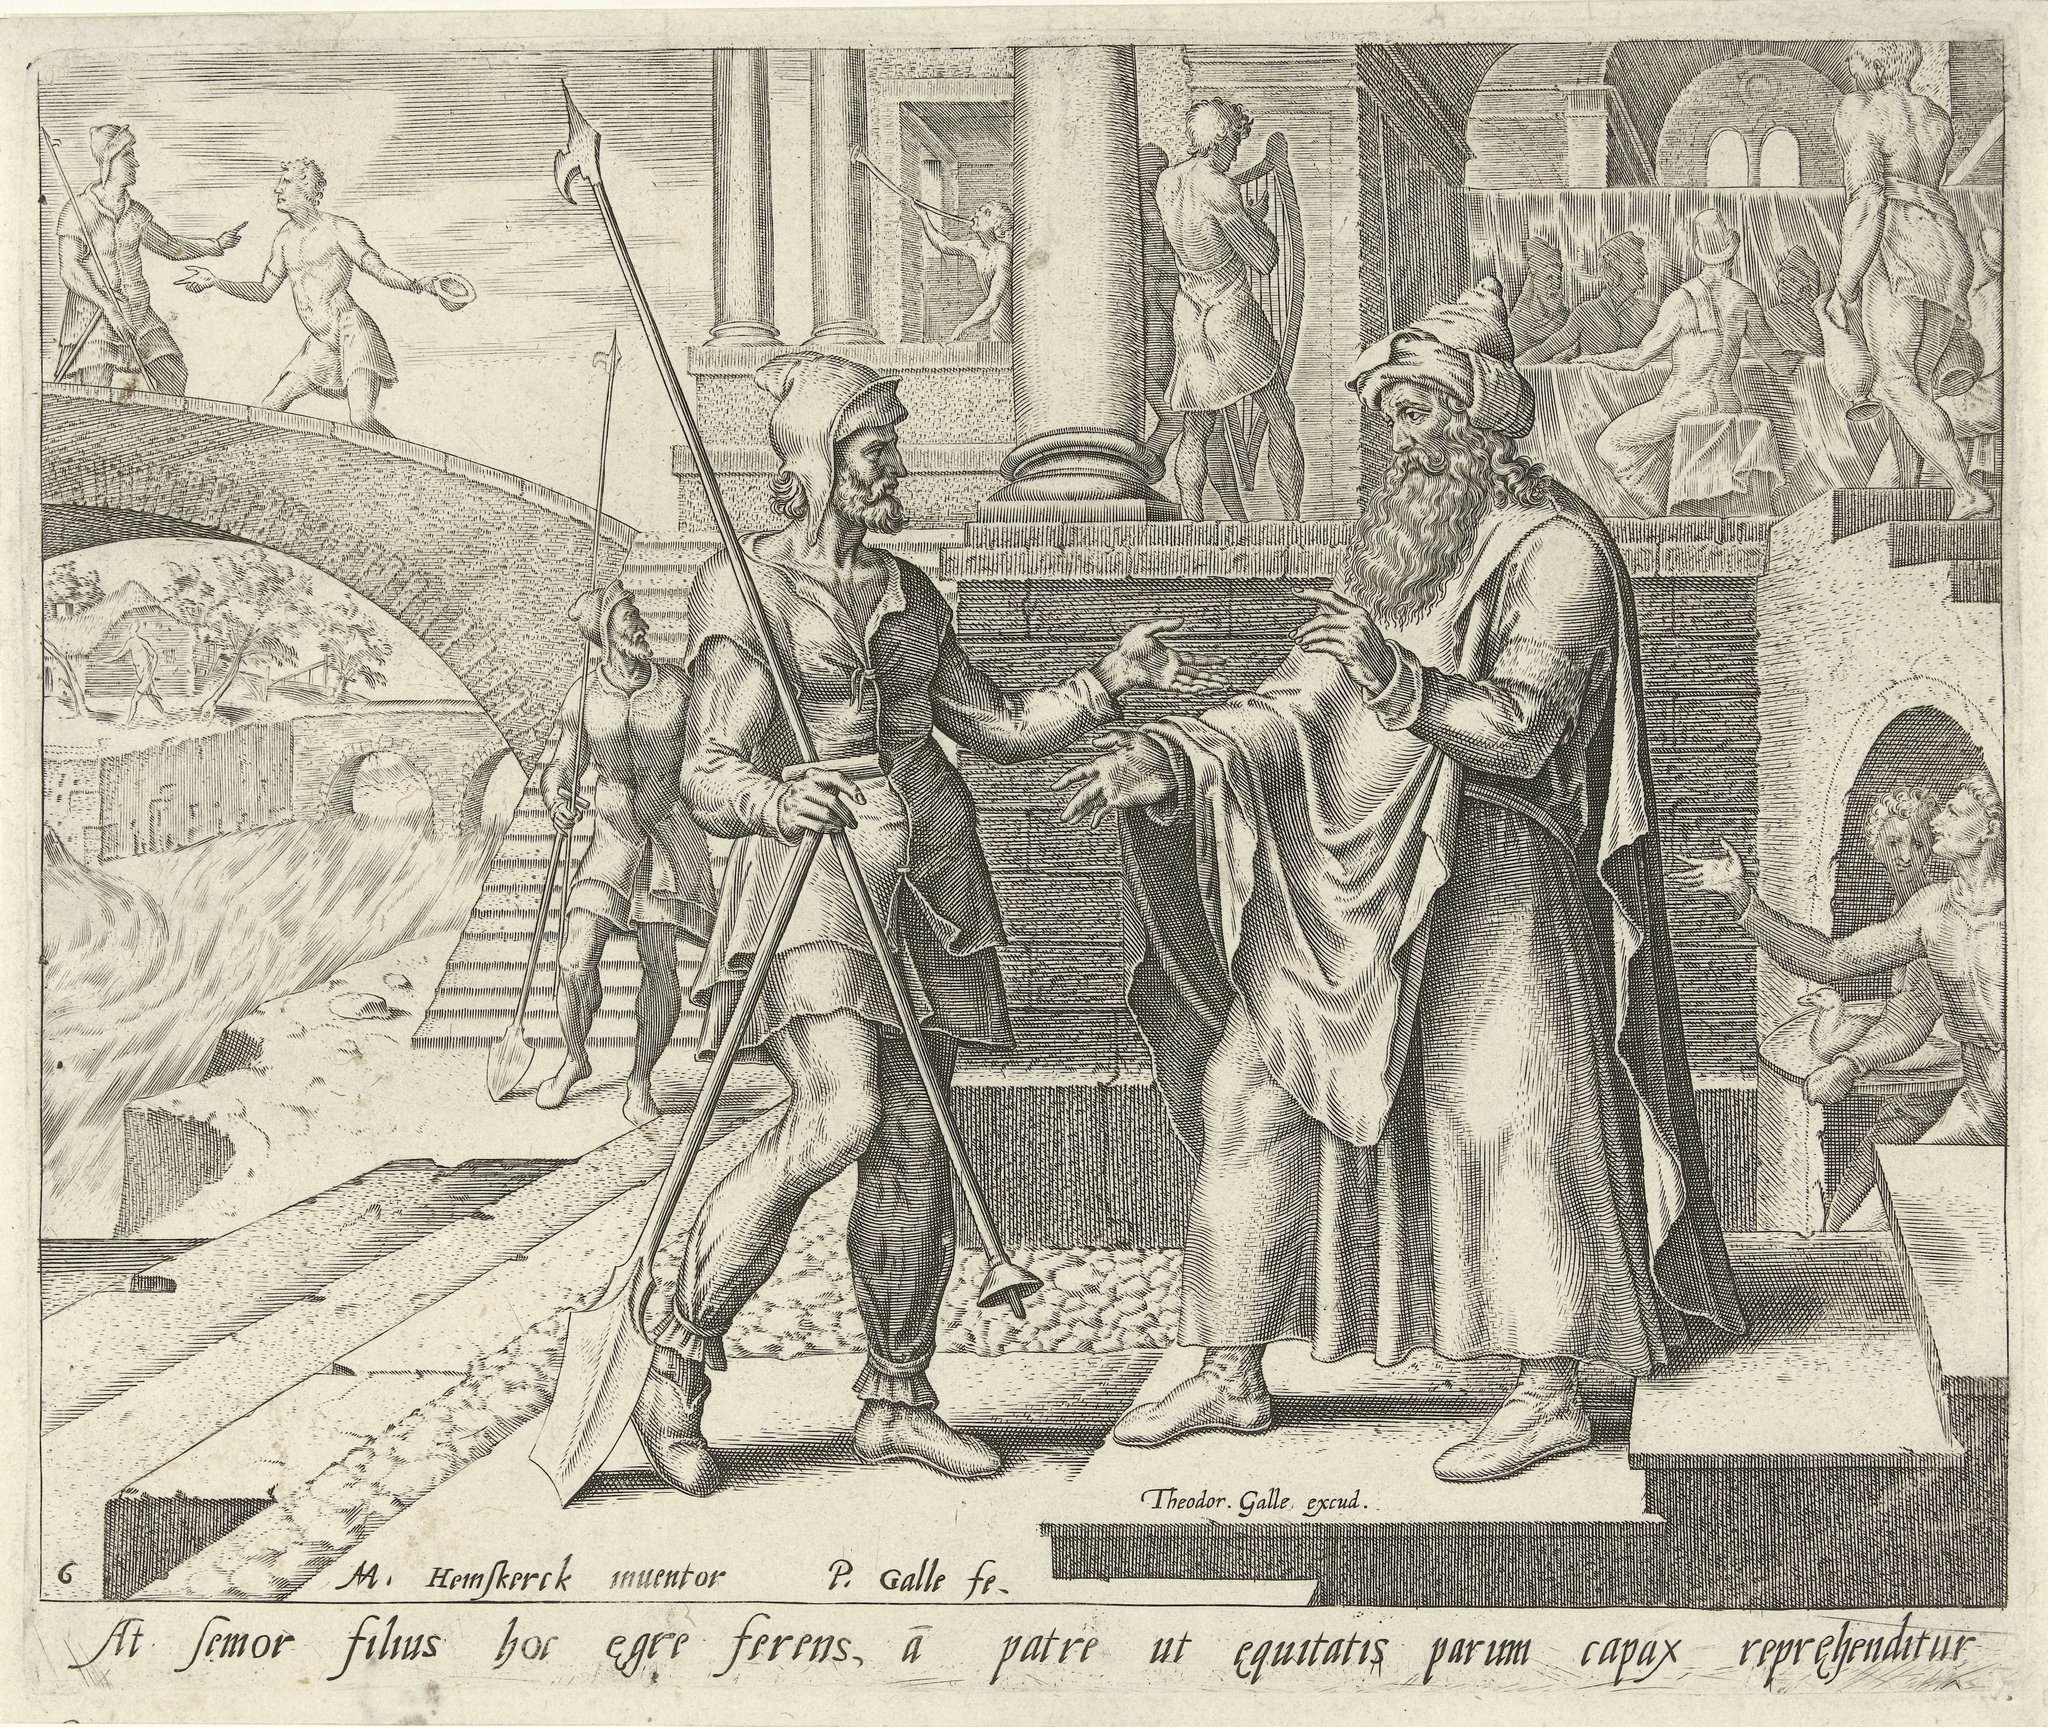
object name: print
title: Gelijkenis van de verloren zoon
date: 1596-1633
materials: paper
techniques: engraving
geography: antwerp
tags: preparations, e.g. the prodigal son is given new robes; slaughtering of the fatted calf; the elder son objects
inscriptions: collector's mark: Lugt 2228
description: De oudste broer van de verloren zoon keert terug van het werk op het land en hoort van een dienaar dat zijn broer terug is. Hij is boos over de hartelijk ontvangst van zijn broer die immers al zijn geld heeft verkwist. De vader sust de woede van de oudste zoon.